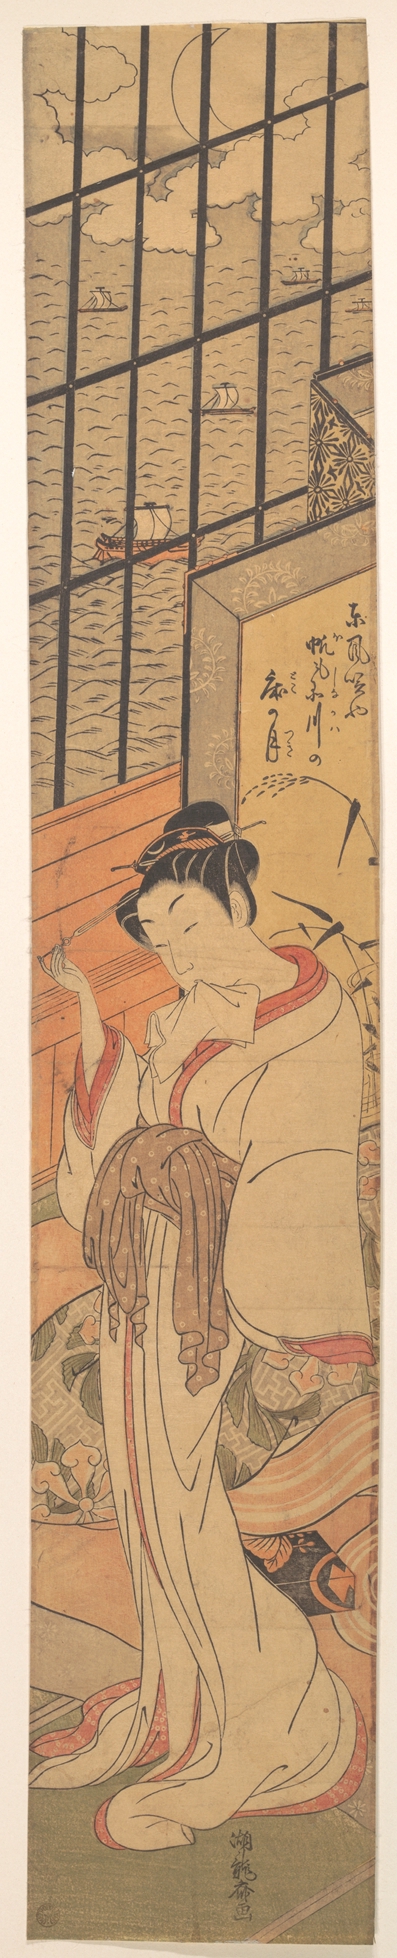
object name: print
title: Moonrise on Edo Bay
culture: japanese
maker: isoda koryūsai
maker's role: artist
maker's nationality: japanese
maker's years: 1735-1790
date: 1770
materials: ink, paper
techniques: woodblock print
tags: women,boats